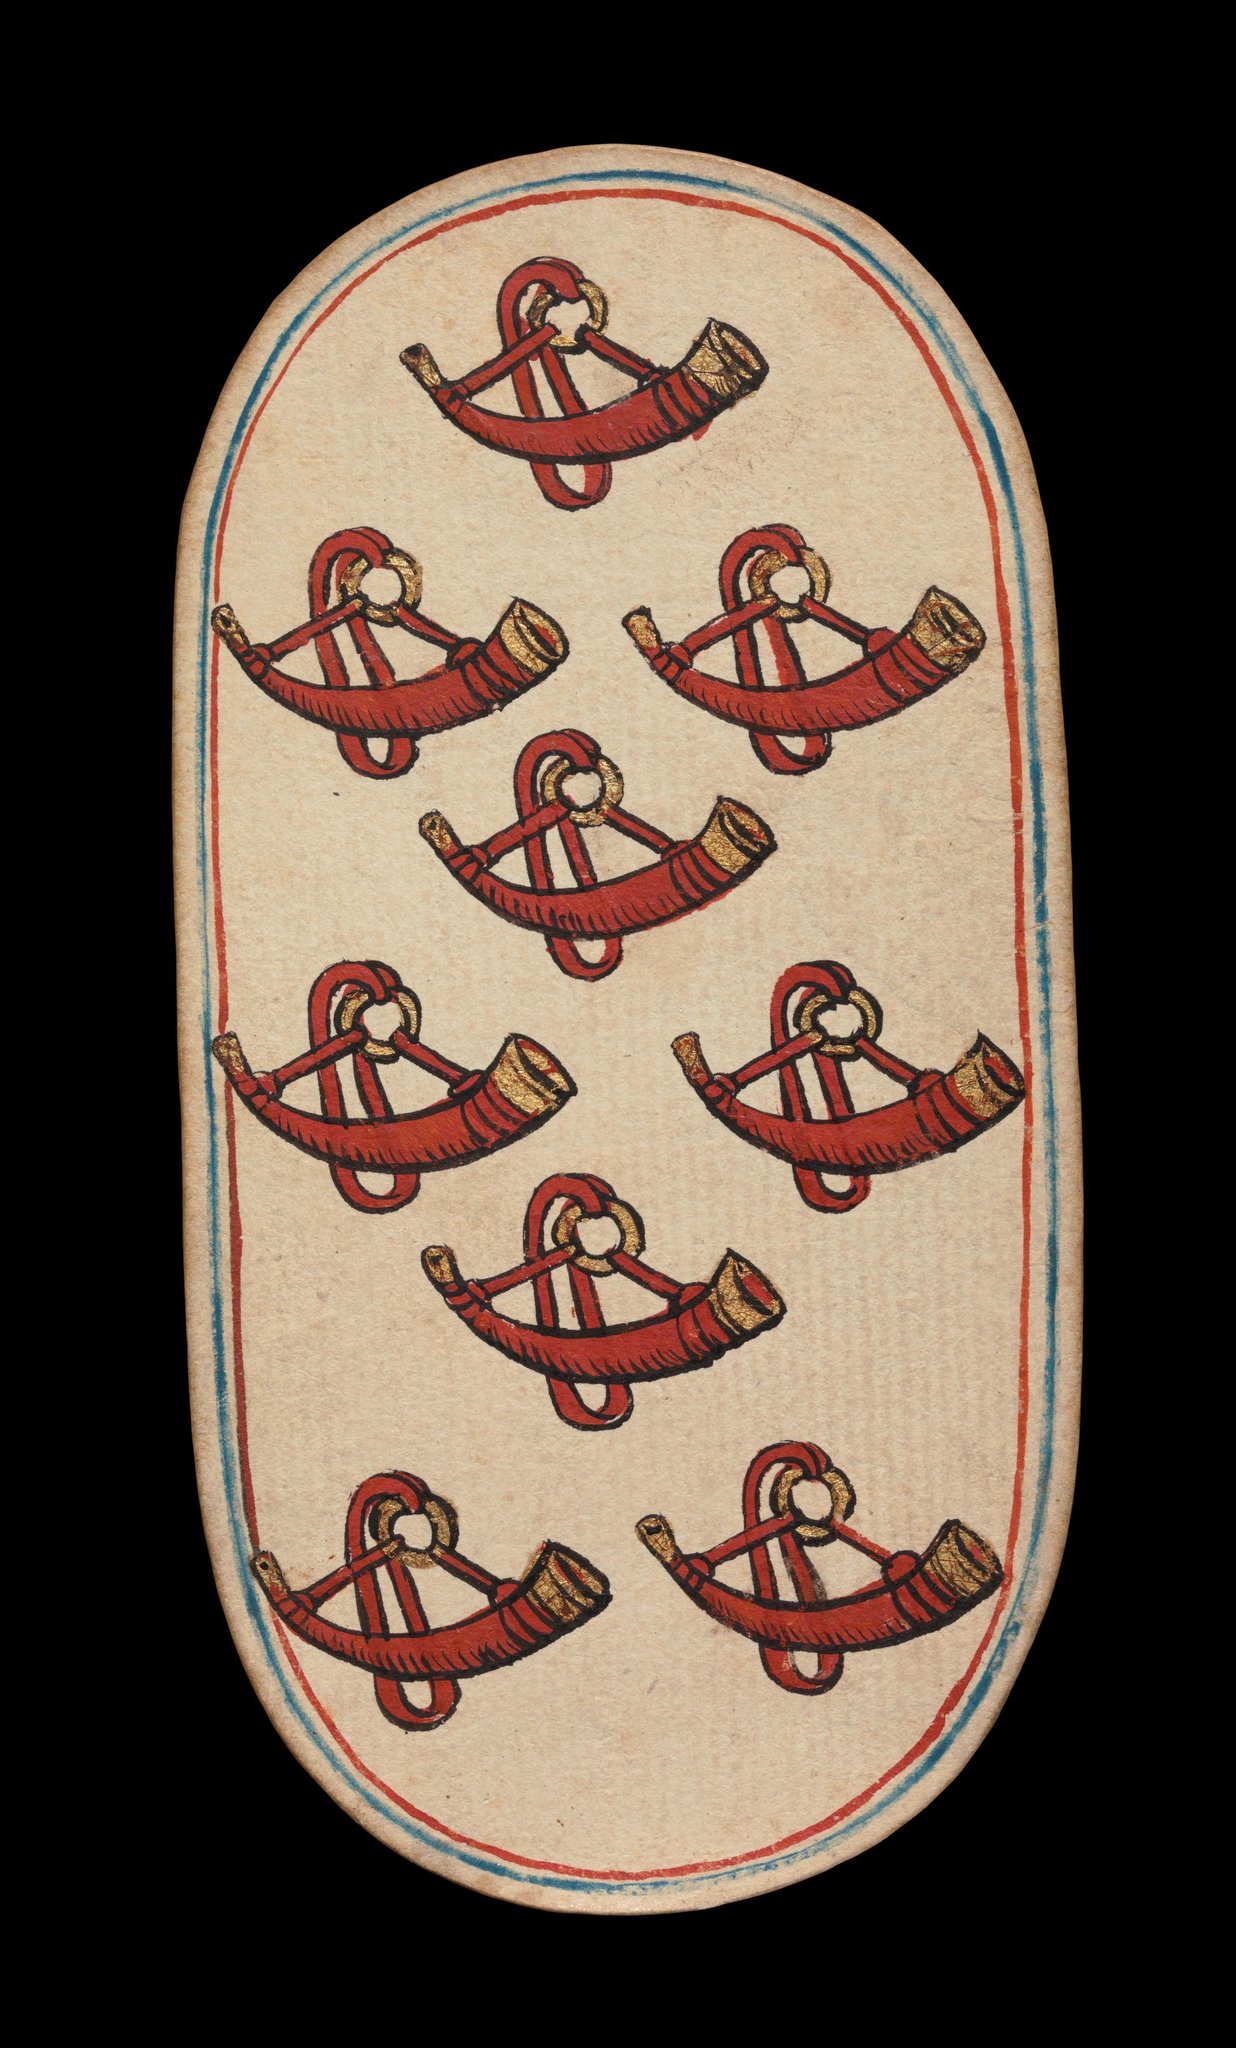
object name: playing card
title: 9 of Horns, from The Cloisters Playing Cards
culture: south netherlandish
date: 1475-1480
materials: glaze, gold, ink, paint, paper, silver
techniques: pen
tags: playing cards,horns,games